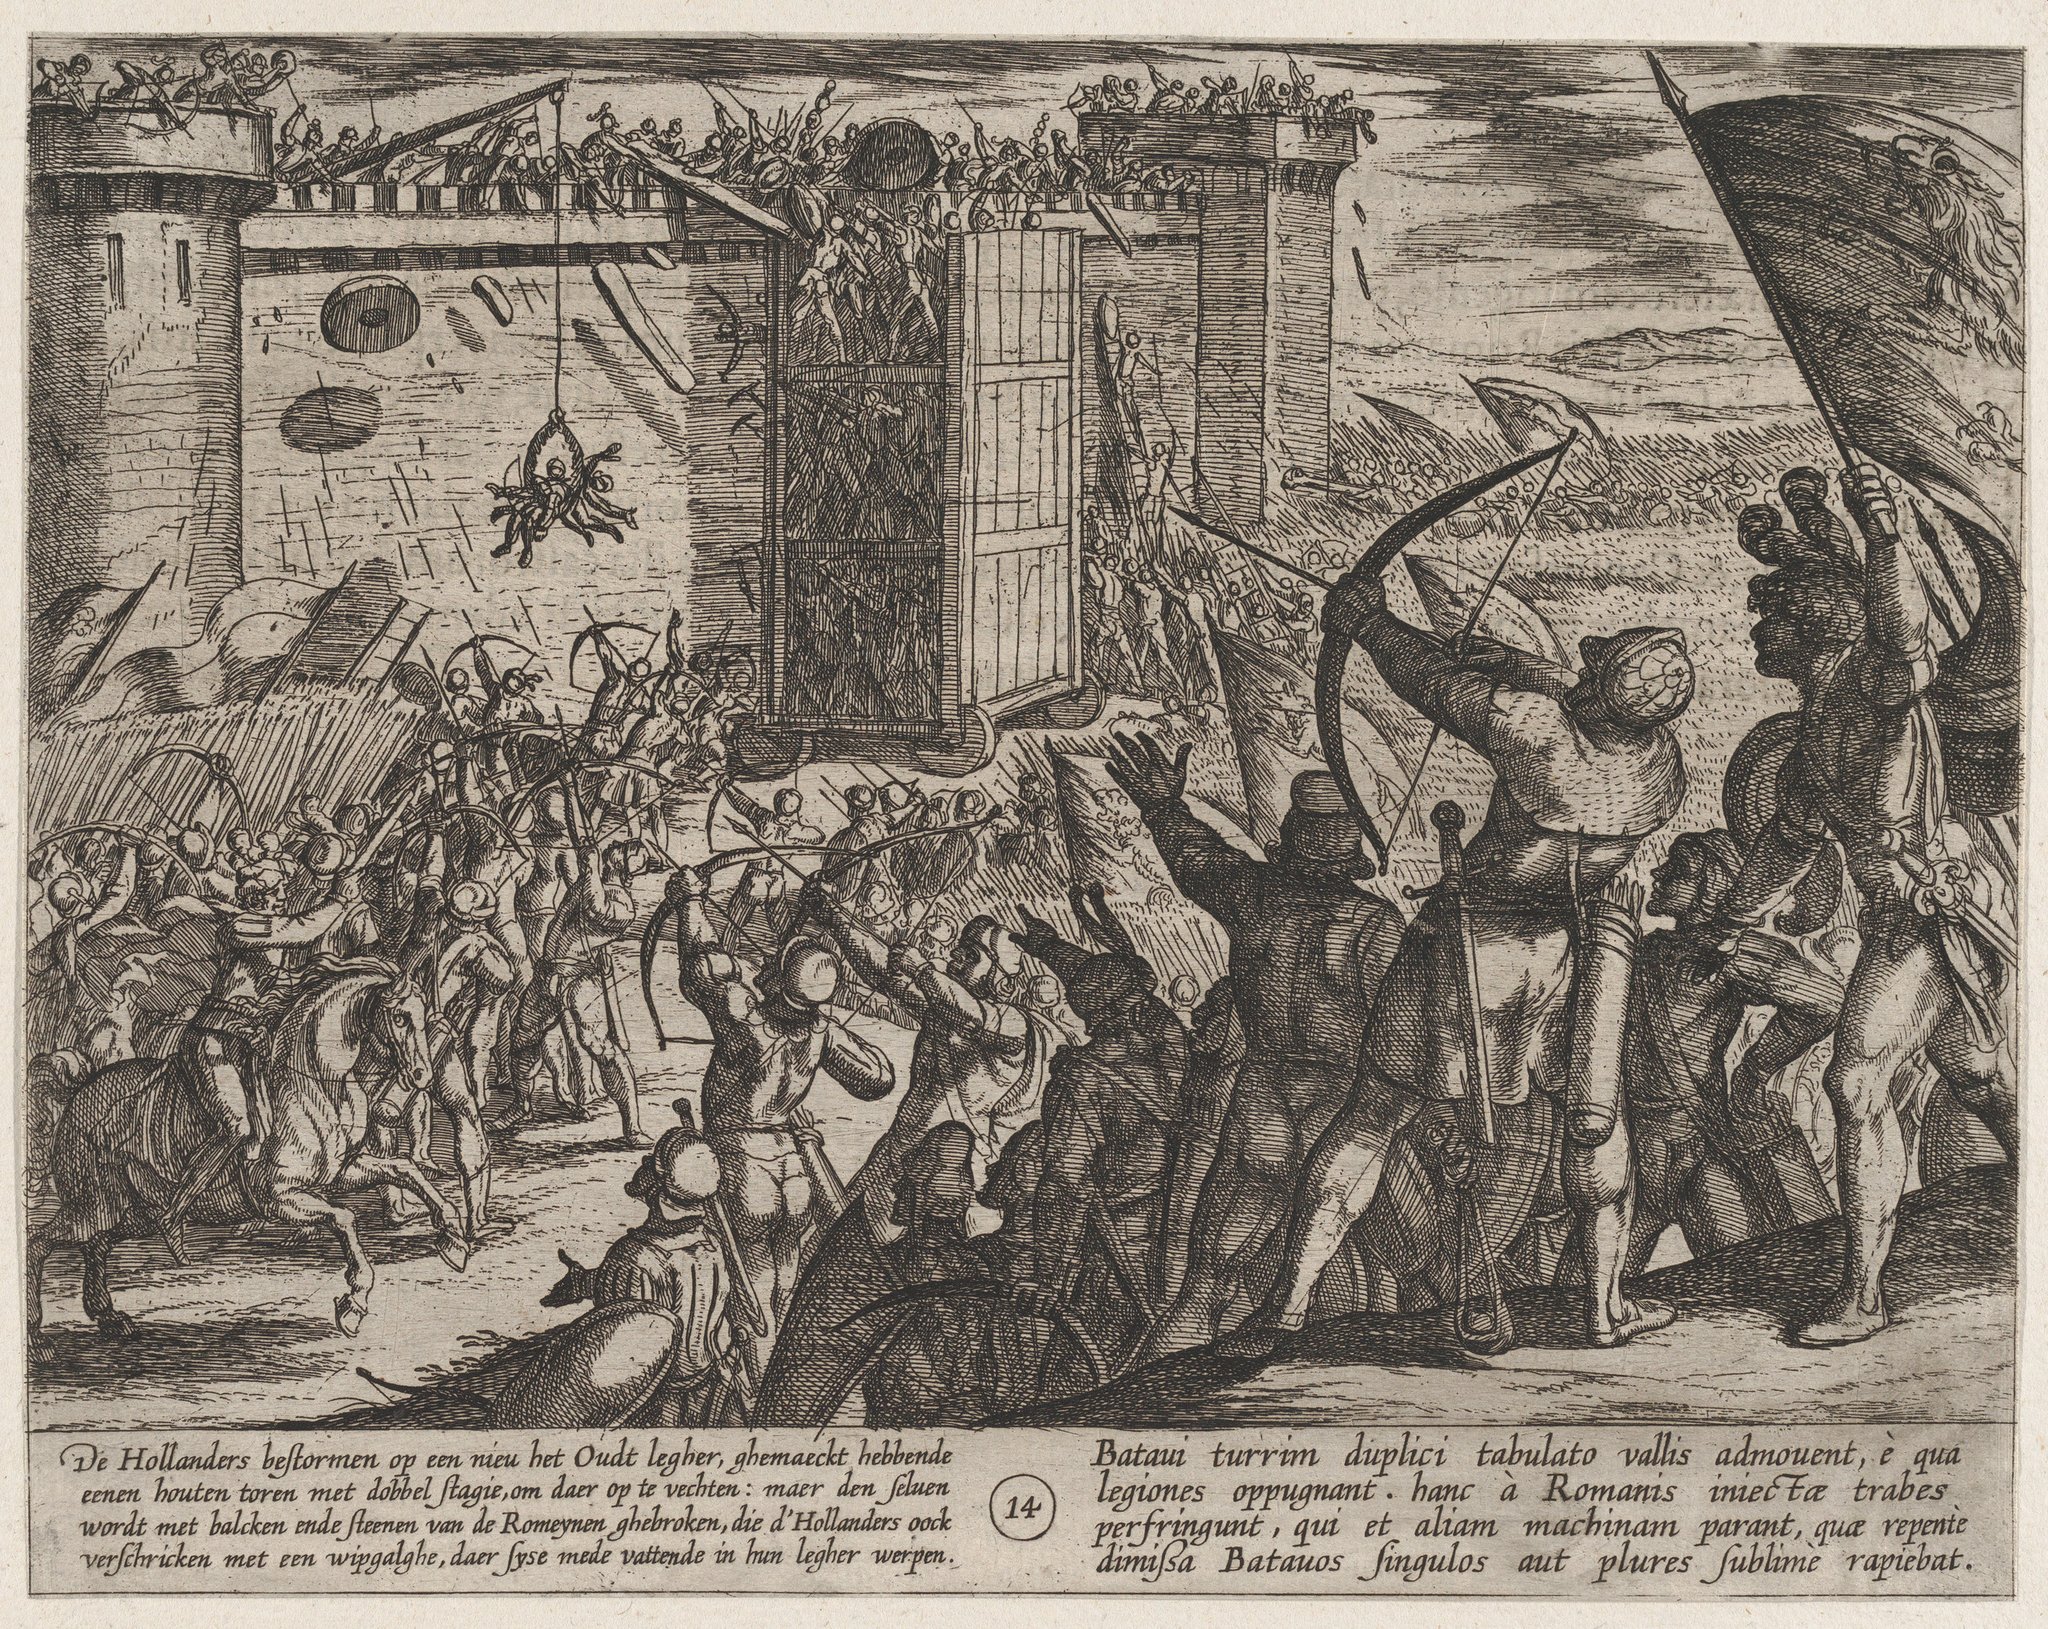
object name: print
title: Plate 14: New Attack on the Old Fortress, from The War of the Romans Against the Batavians (Romanorvm et Batavorvm societas)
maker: antonio tempesta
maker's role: artist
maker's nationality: italian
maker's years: 1555-1630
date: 1611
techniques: etching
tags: castles,wars,soldiers,bow and arrow,horses